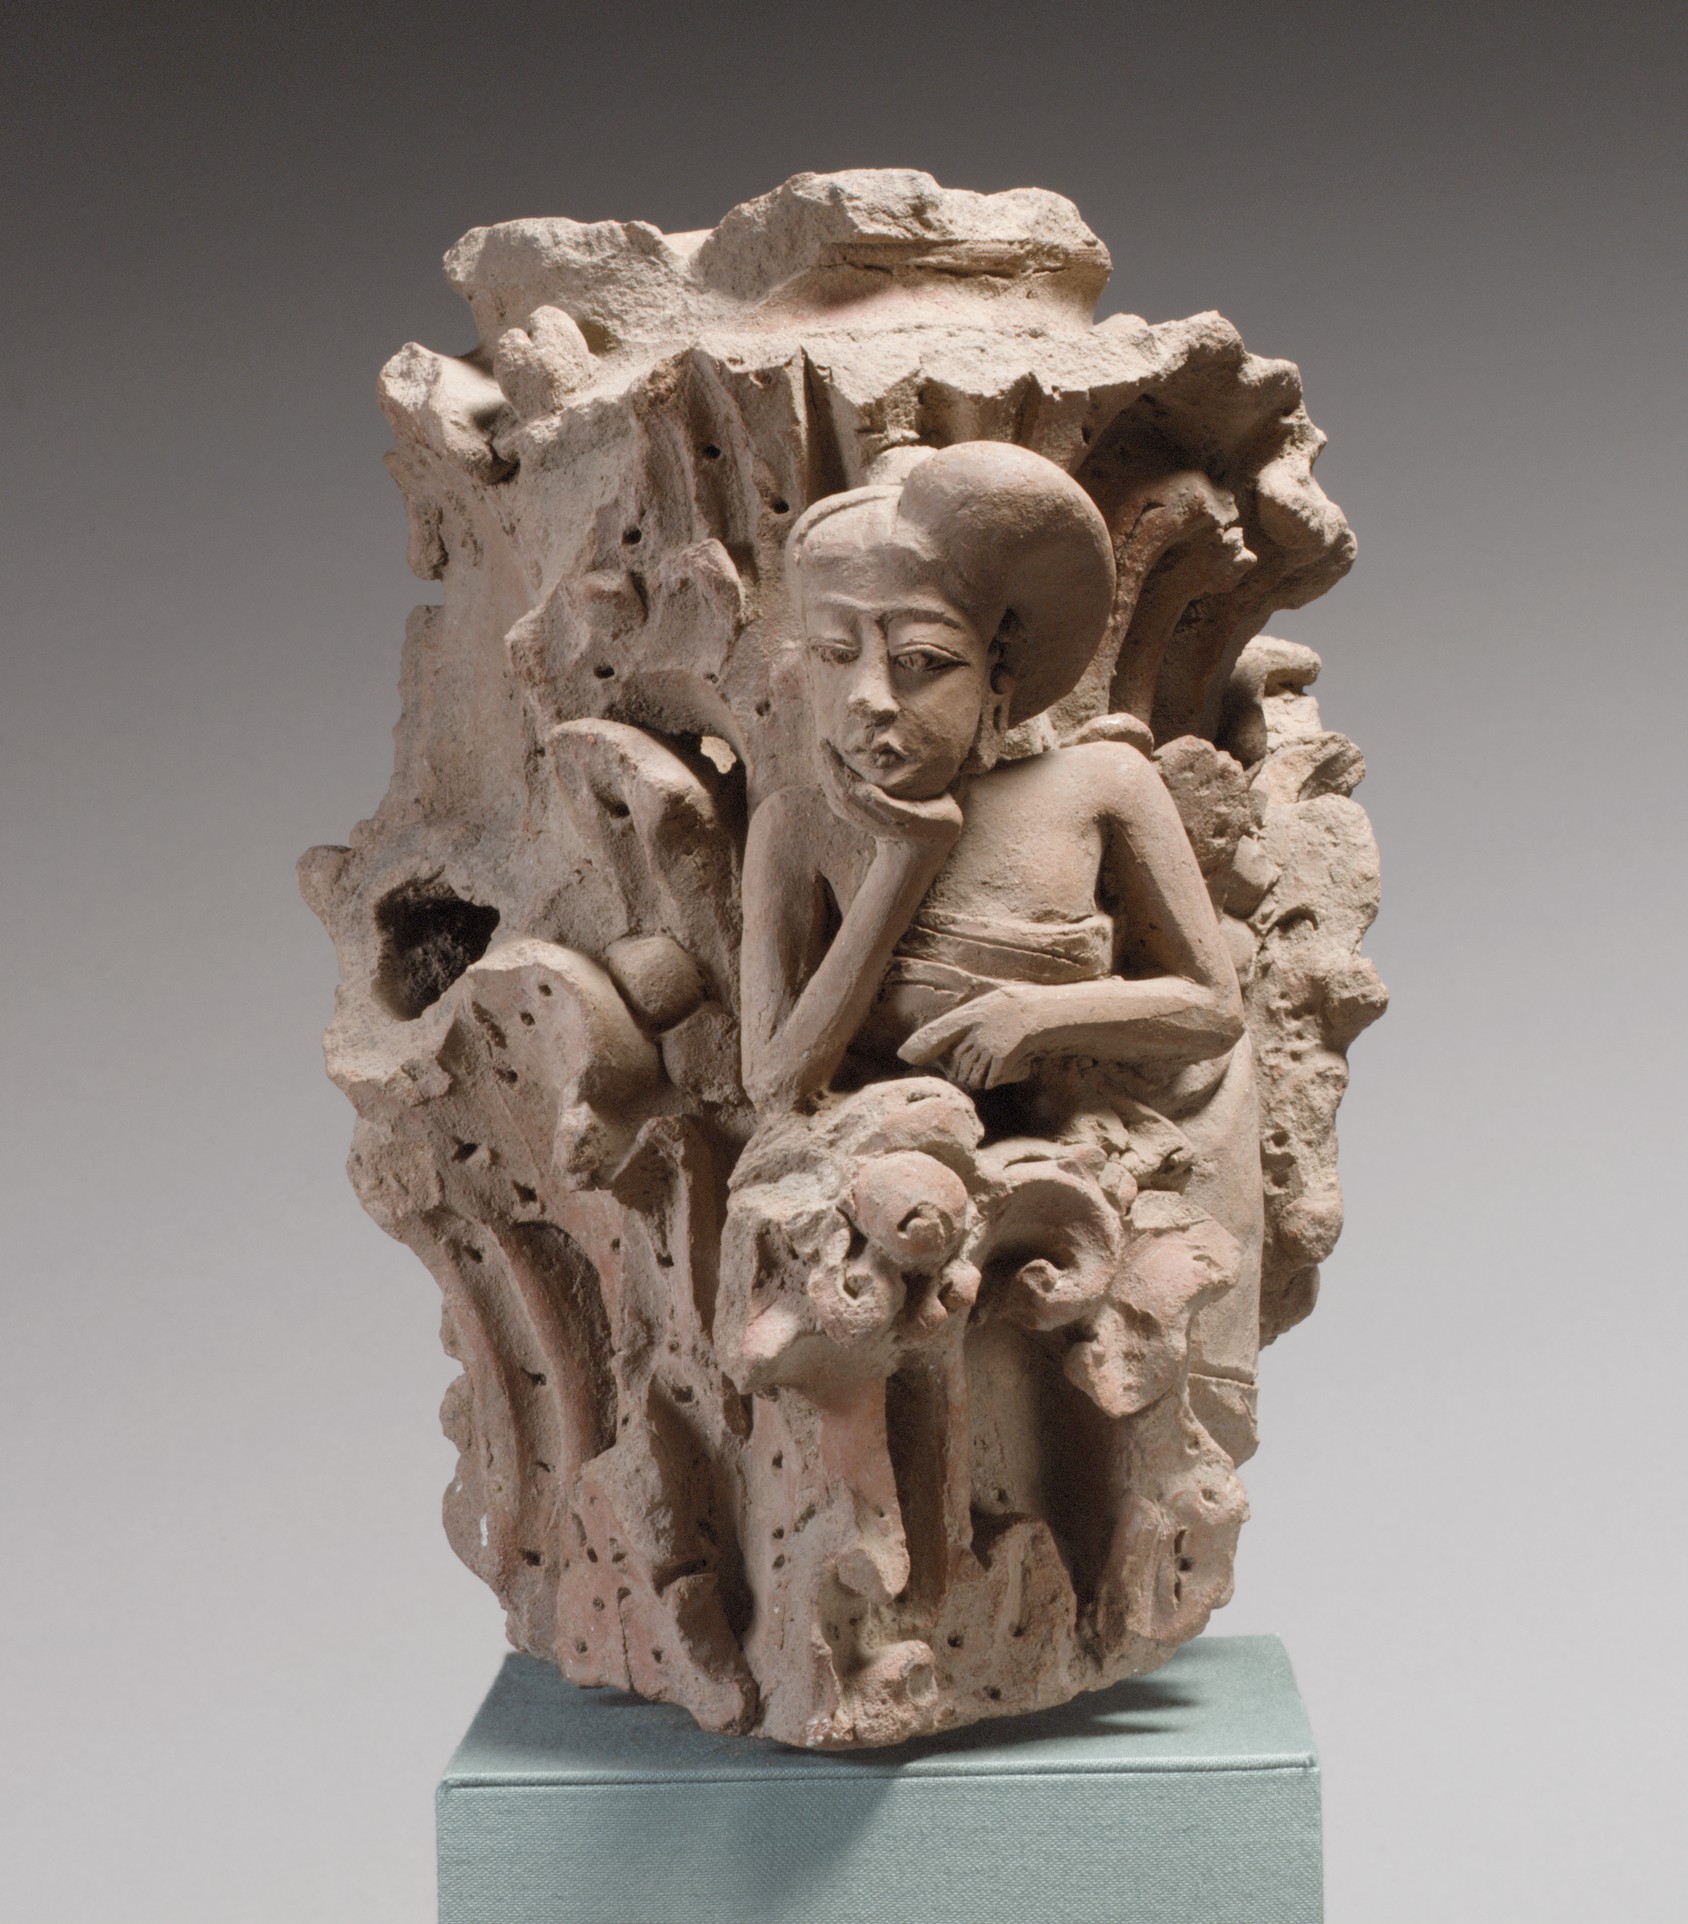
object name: column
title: Column Surround with Pensive Woman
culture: indonesian, javanese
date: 1301-1500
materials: terracotta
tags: contemplation,women